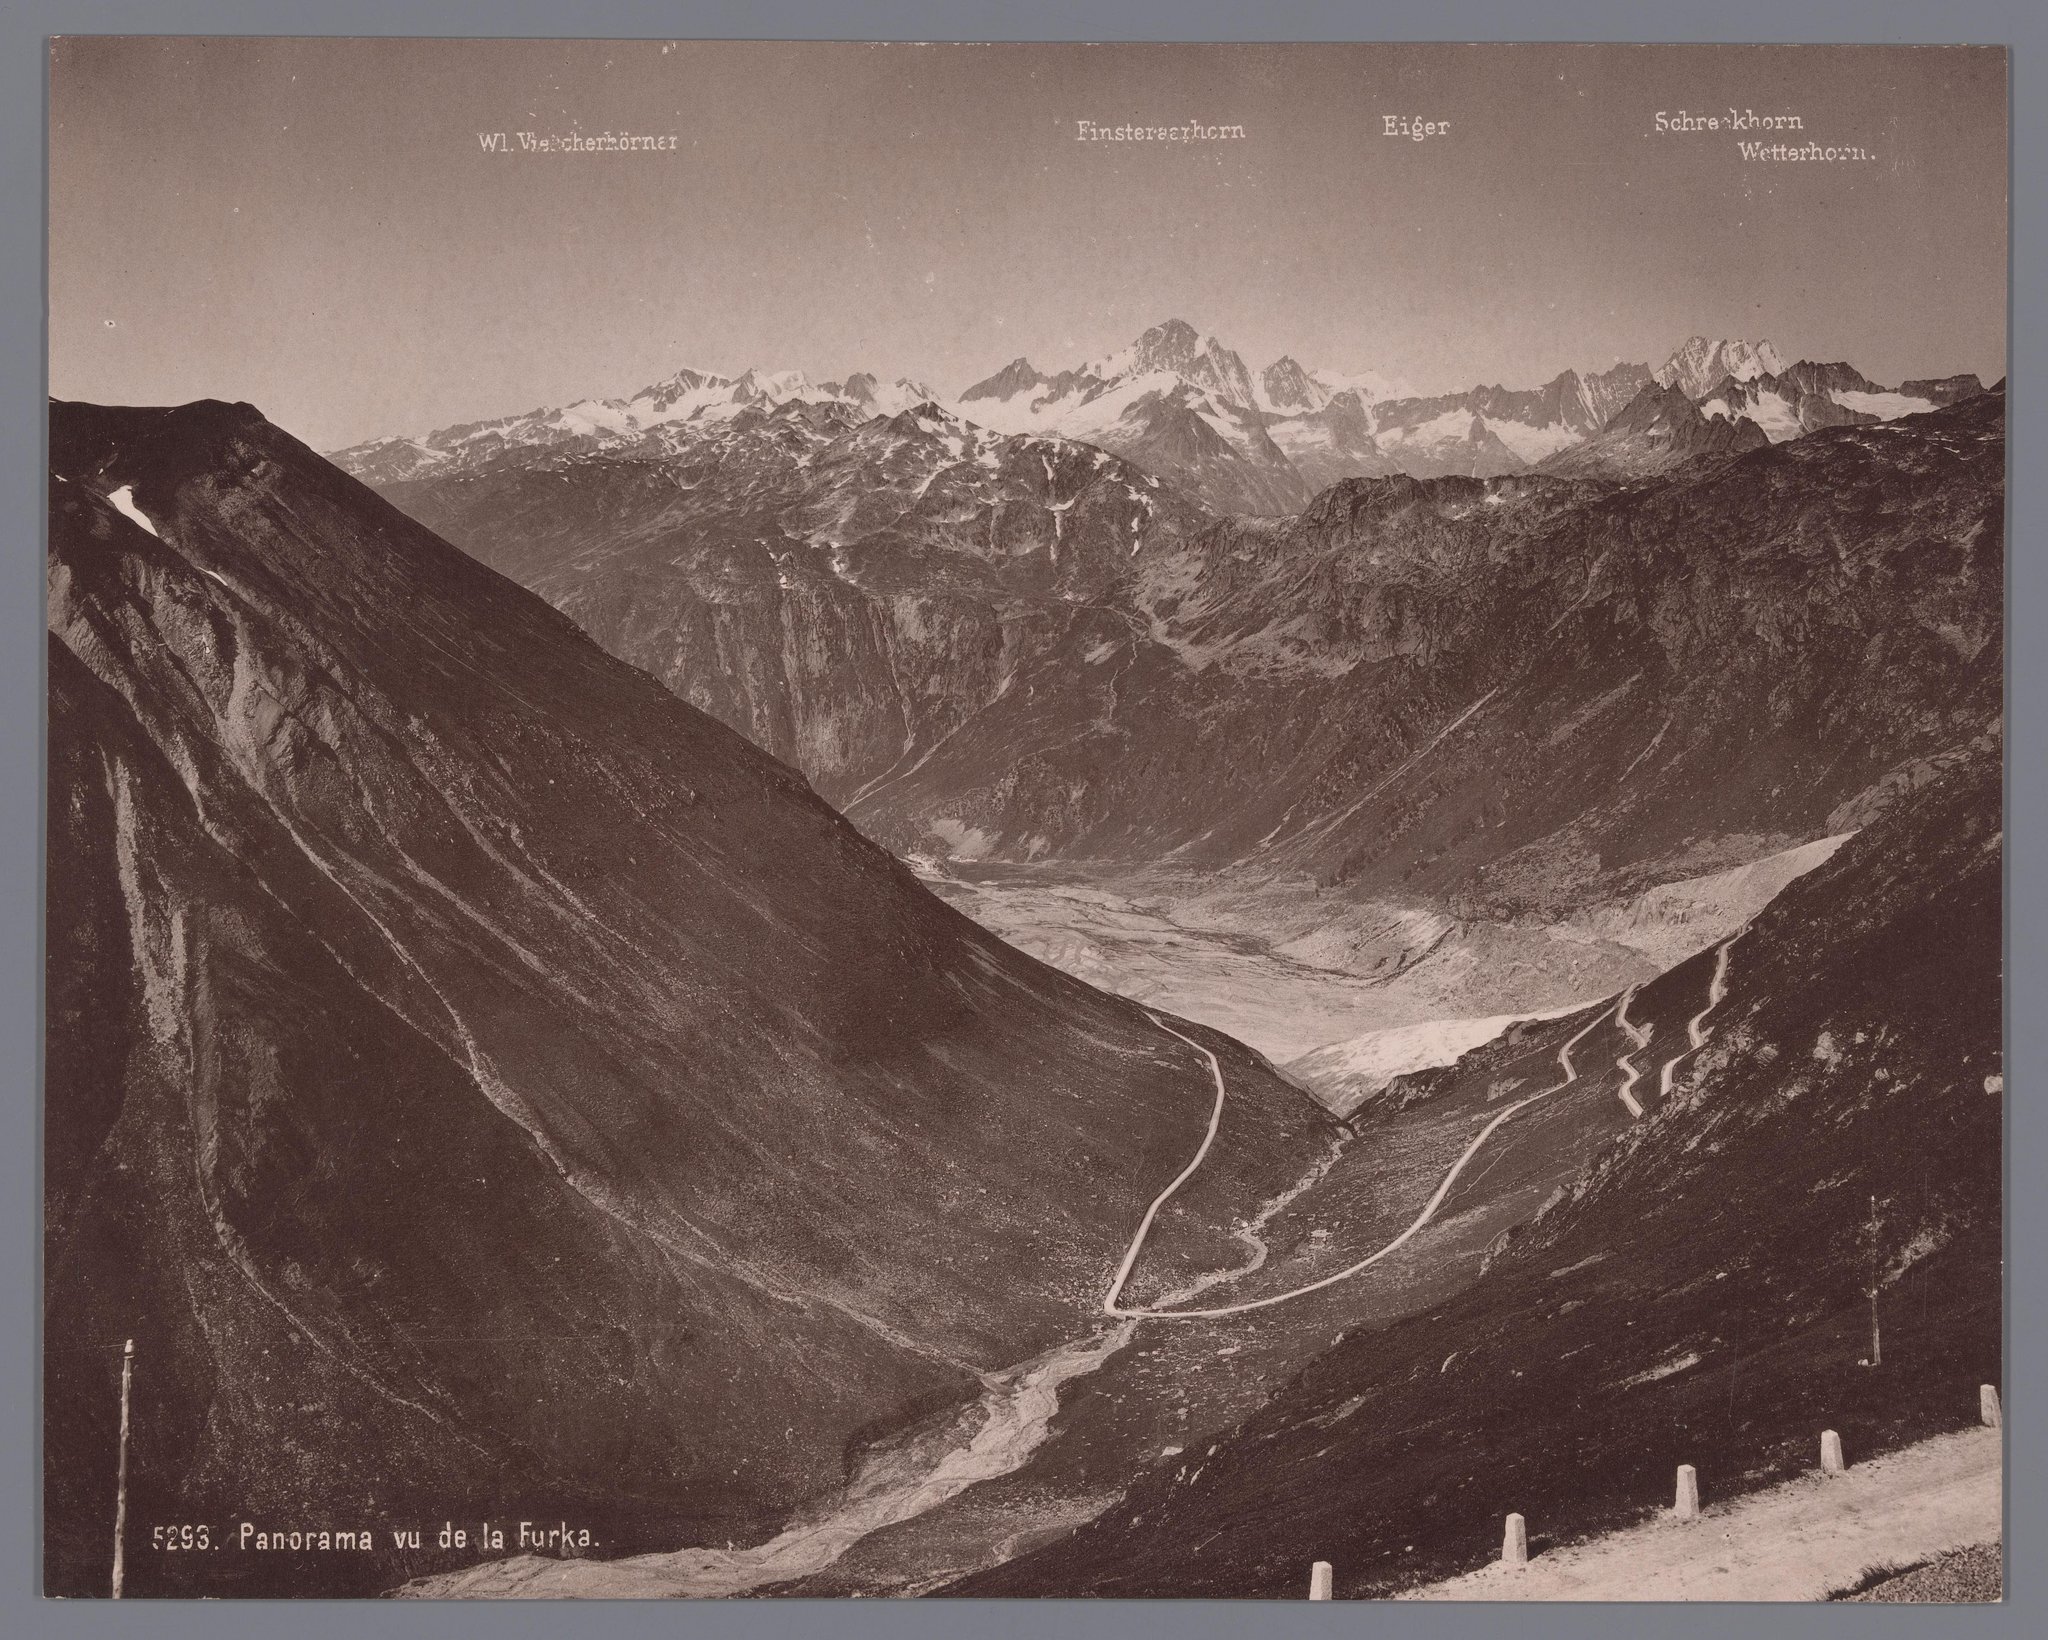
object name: photomechanical print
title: Gezicht op de Furkapas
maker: Anonymous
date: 1870-1930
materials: cardboard, paper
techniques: photograph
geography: furkapas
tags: dale, valley, mountains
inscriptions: inscription: ‘W1. Visscherhörnar Finsteraarhorn Eiger Schreckhorn/ Wetterhorn.’, number: ‘5293.’